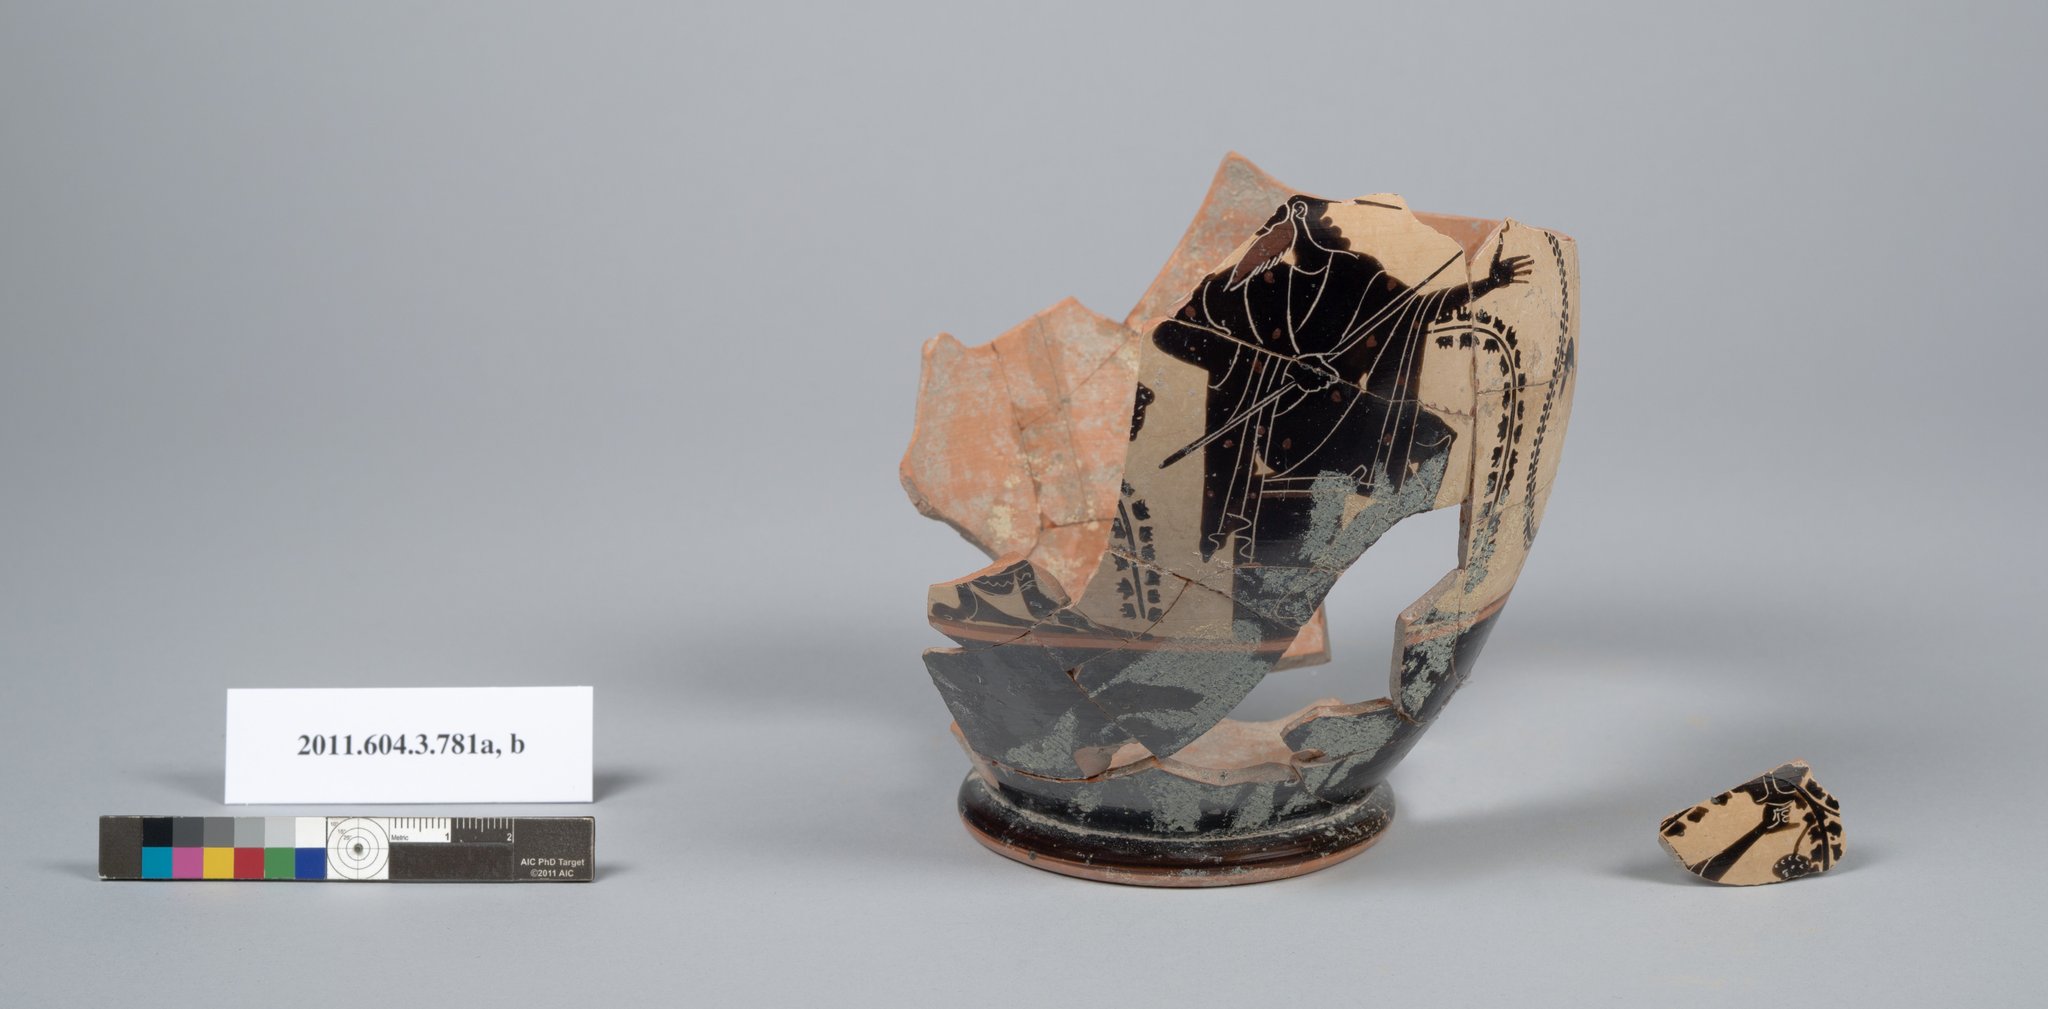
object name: oinochoe fragment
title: Terracotta fragment of an oinochoe (jug)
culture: greek, attic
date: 534-468 BCE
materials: terracotta